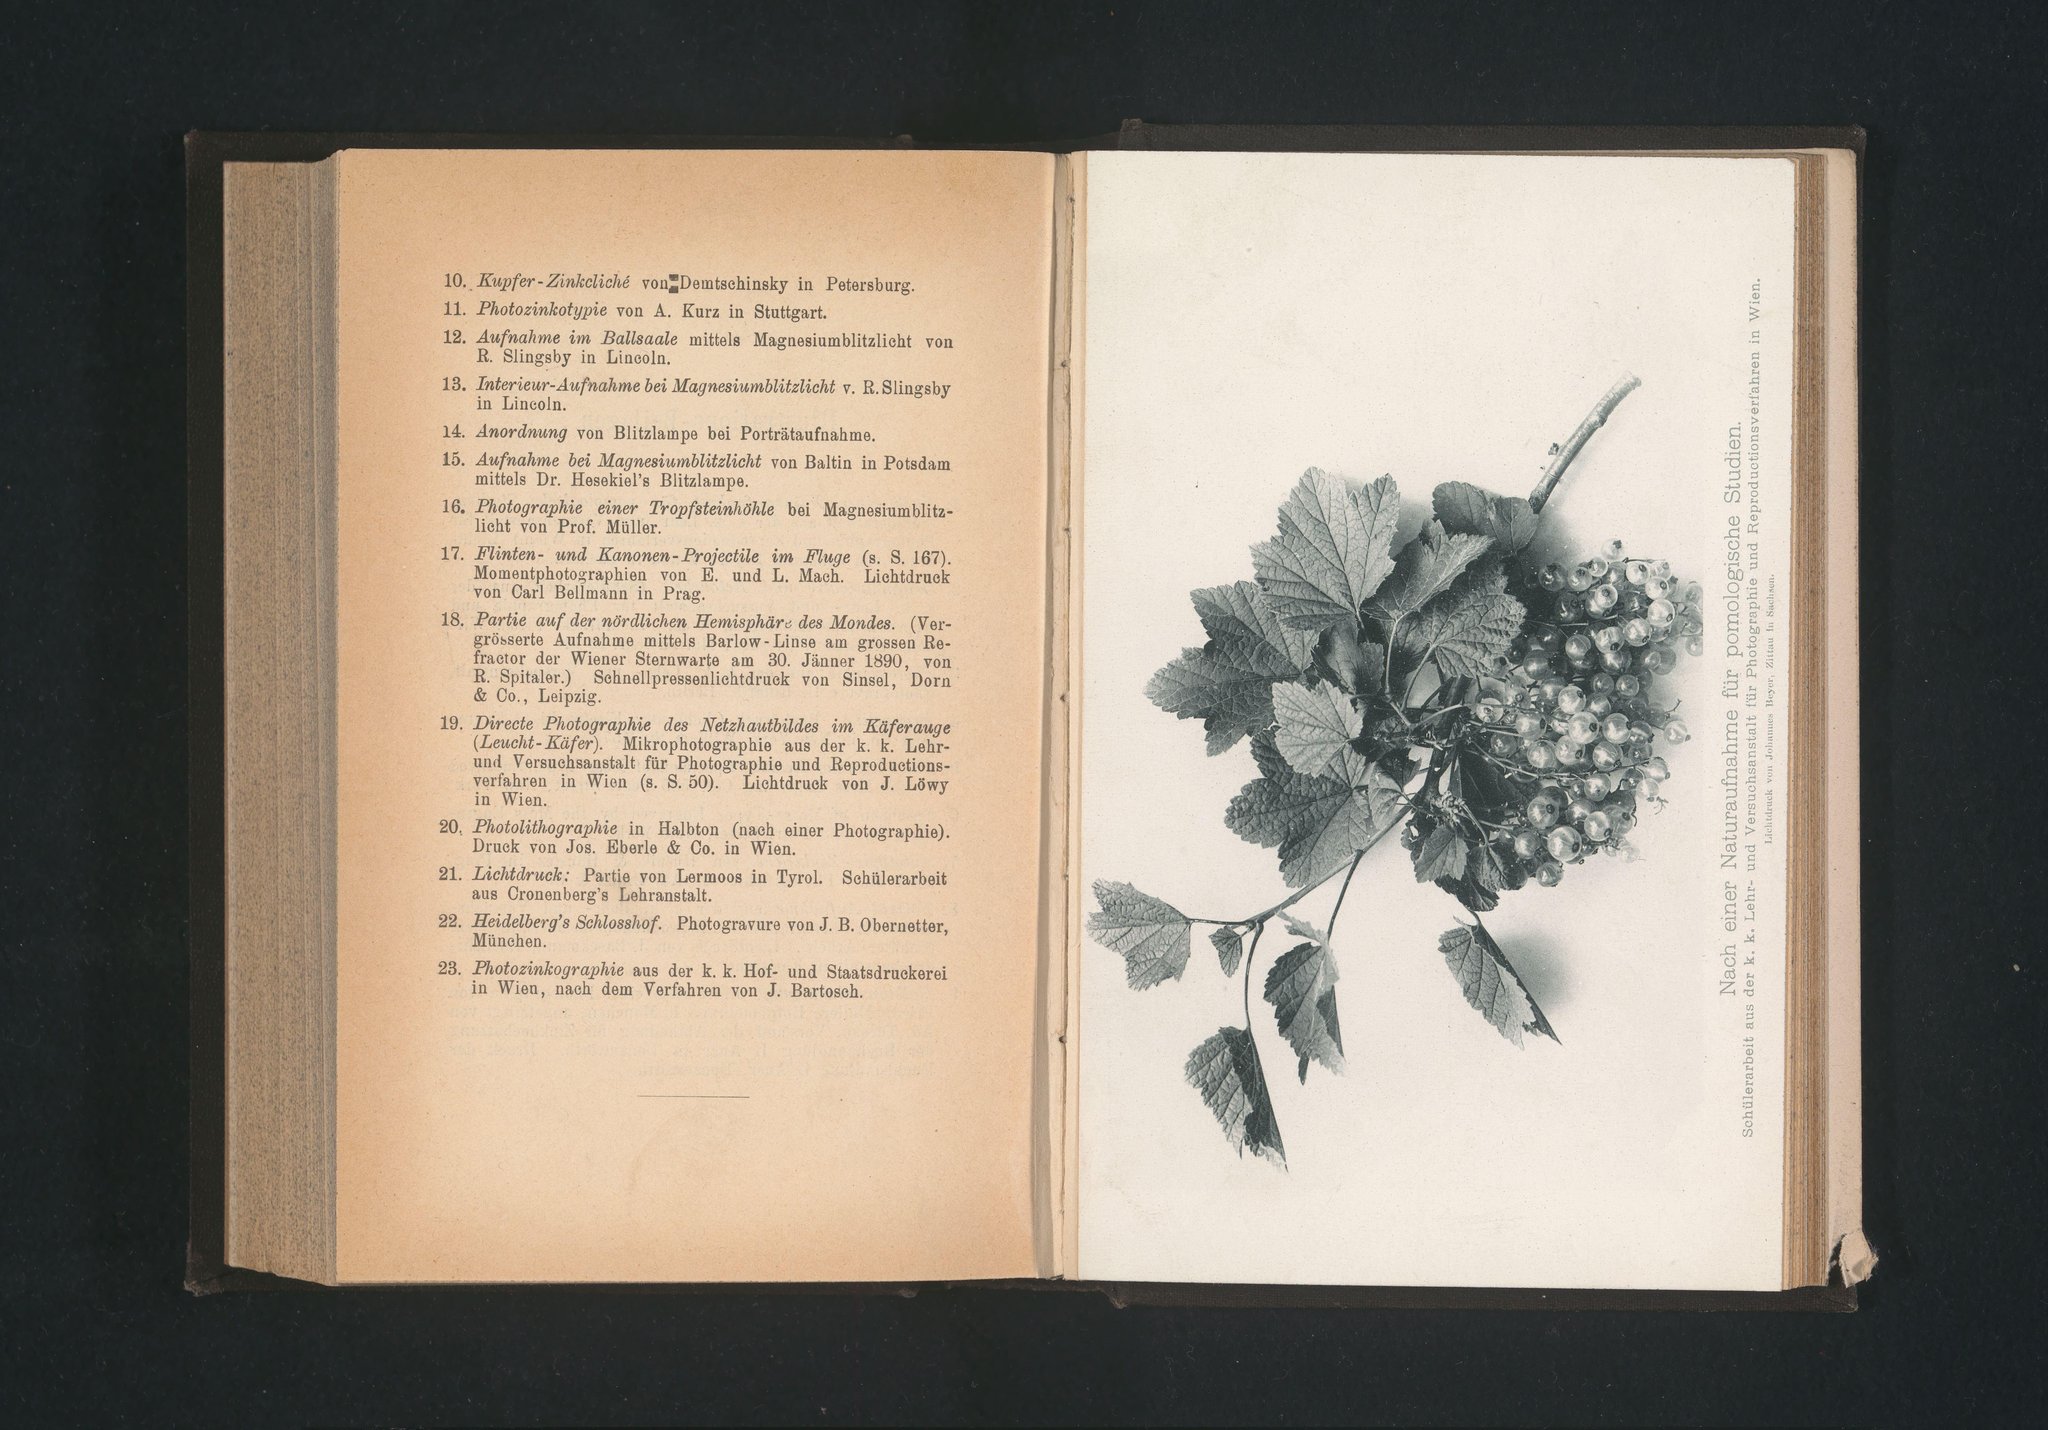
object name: page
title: Tros rode bessen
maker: johannes beyer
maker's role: clichémaker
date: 1886-1891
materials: paper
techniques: photograph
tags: plants (in general)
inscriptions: inscription: ‘Nach einer Naturaufnahme für pmologische Studien’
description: Prent op vierde ongenummerde pagina na pagina 627.